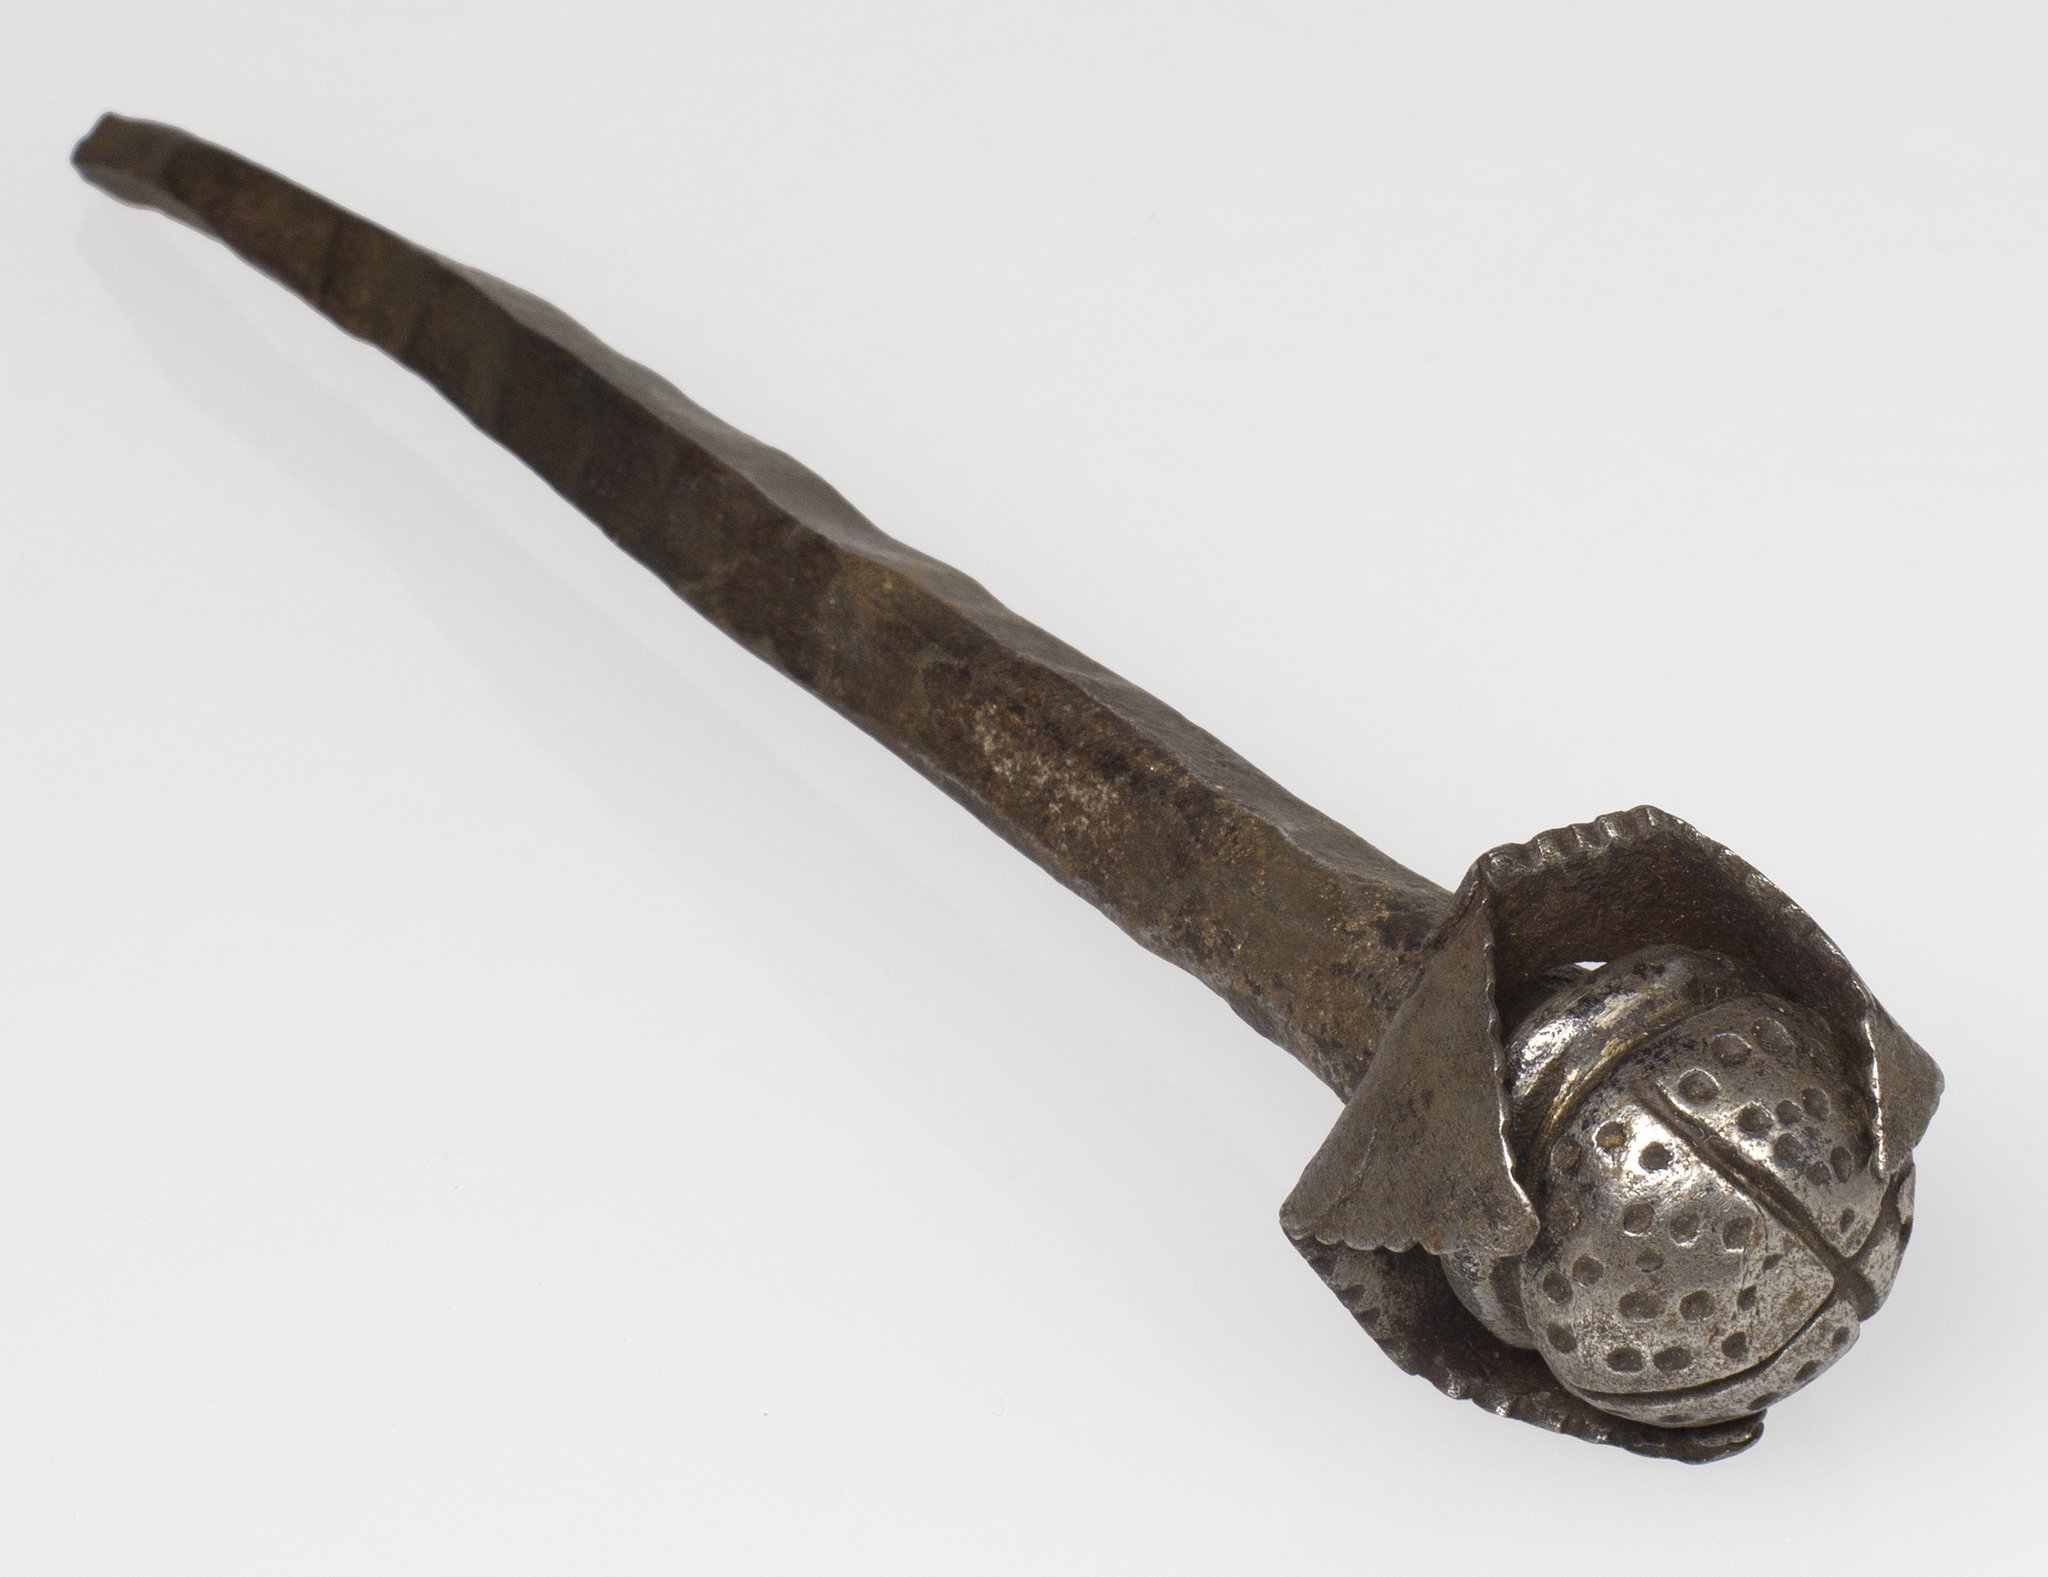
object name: nail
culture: european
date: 1401-1600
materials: iron